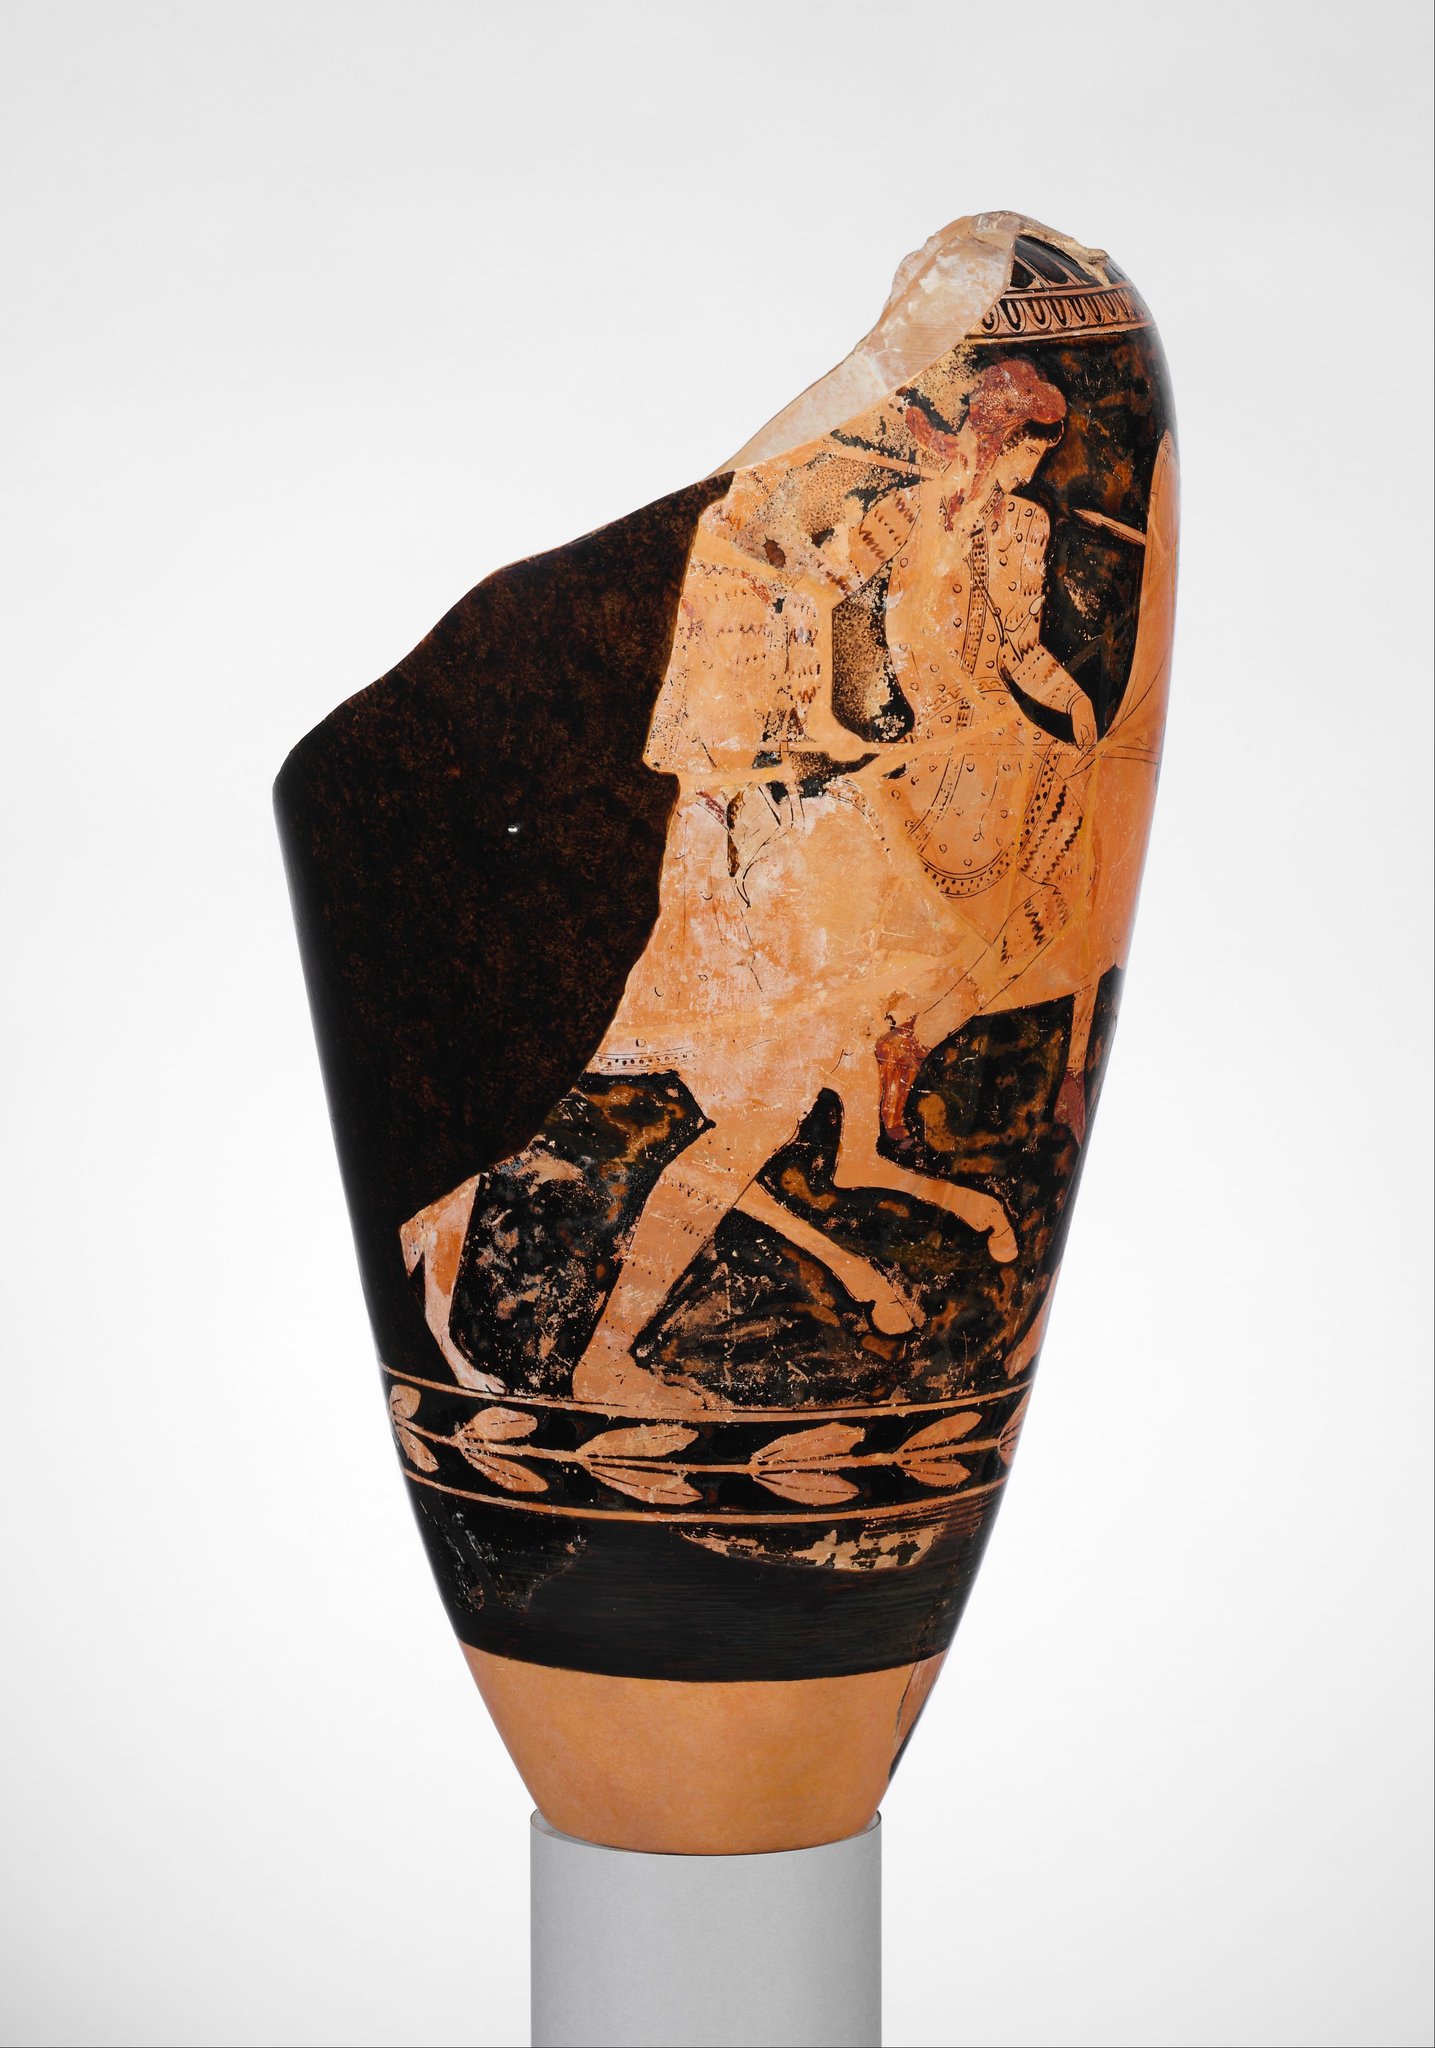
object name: loutrophoros, fragmentary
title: Fragmentary terracotta loutrophoros (ceremonial vase for water)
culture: greek, attic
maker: group of polygnotos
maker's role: artist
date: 440 BCE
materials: terracotta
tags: battles,soldiers,shields,horses